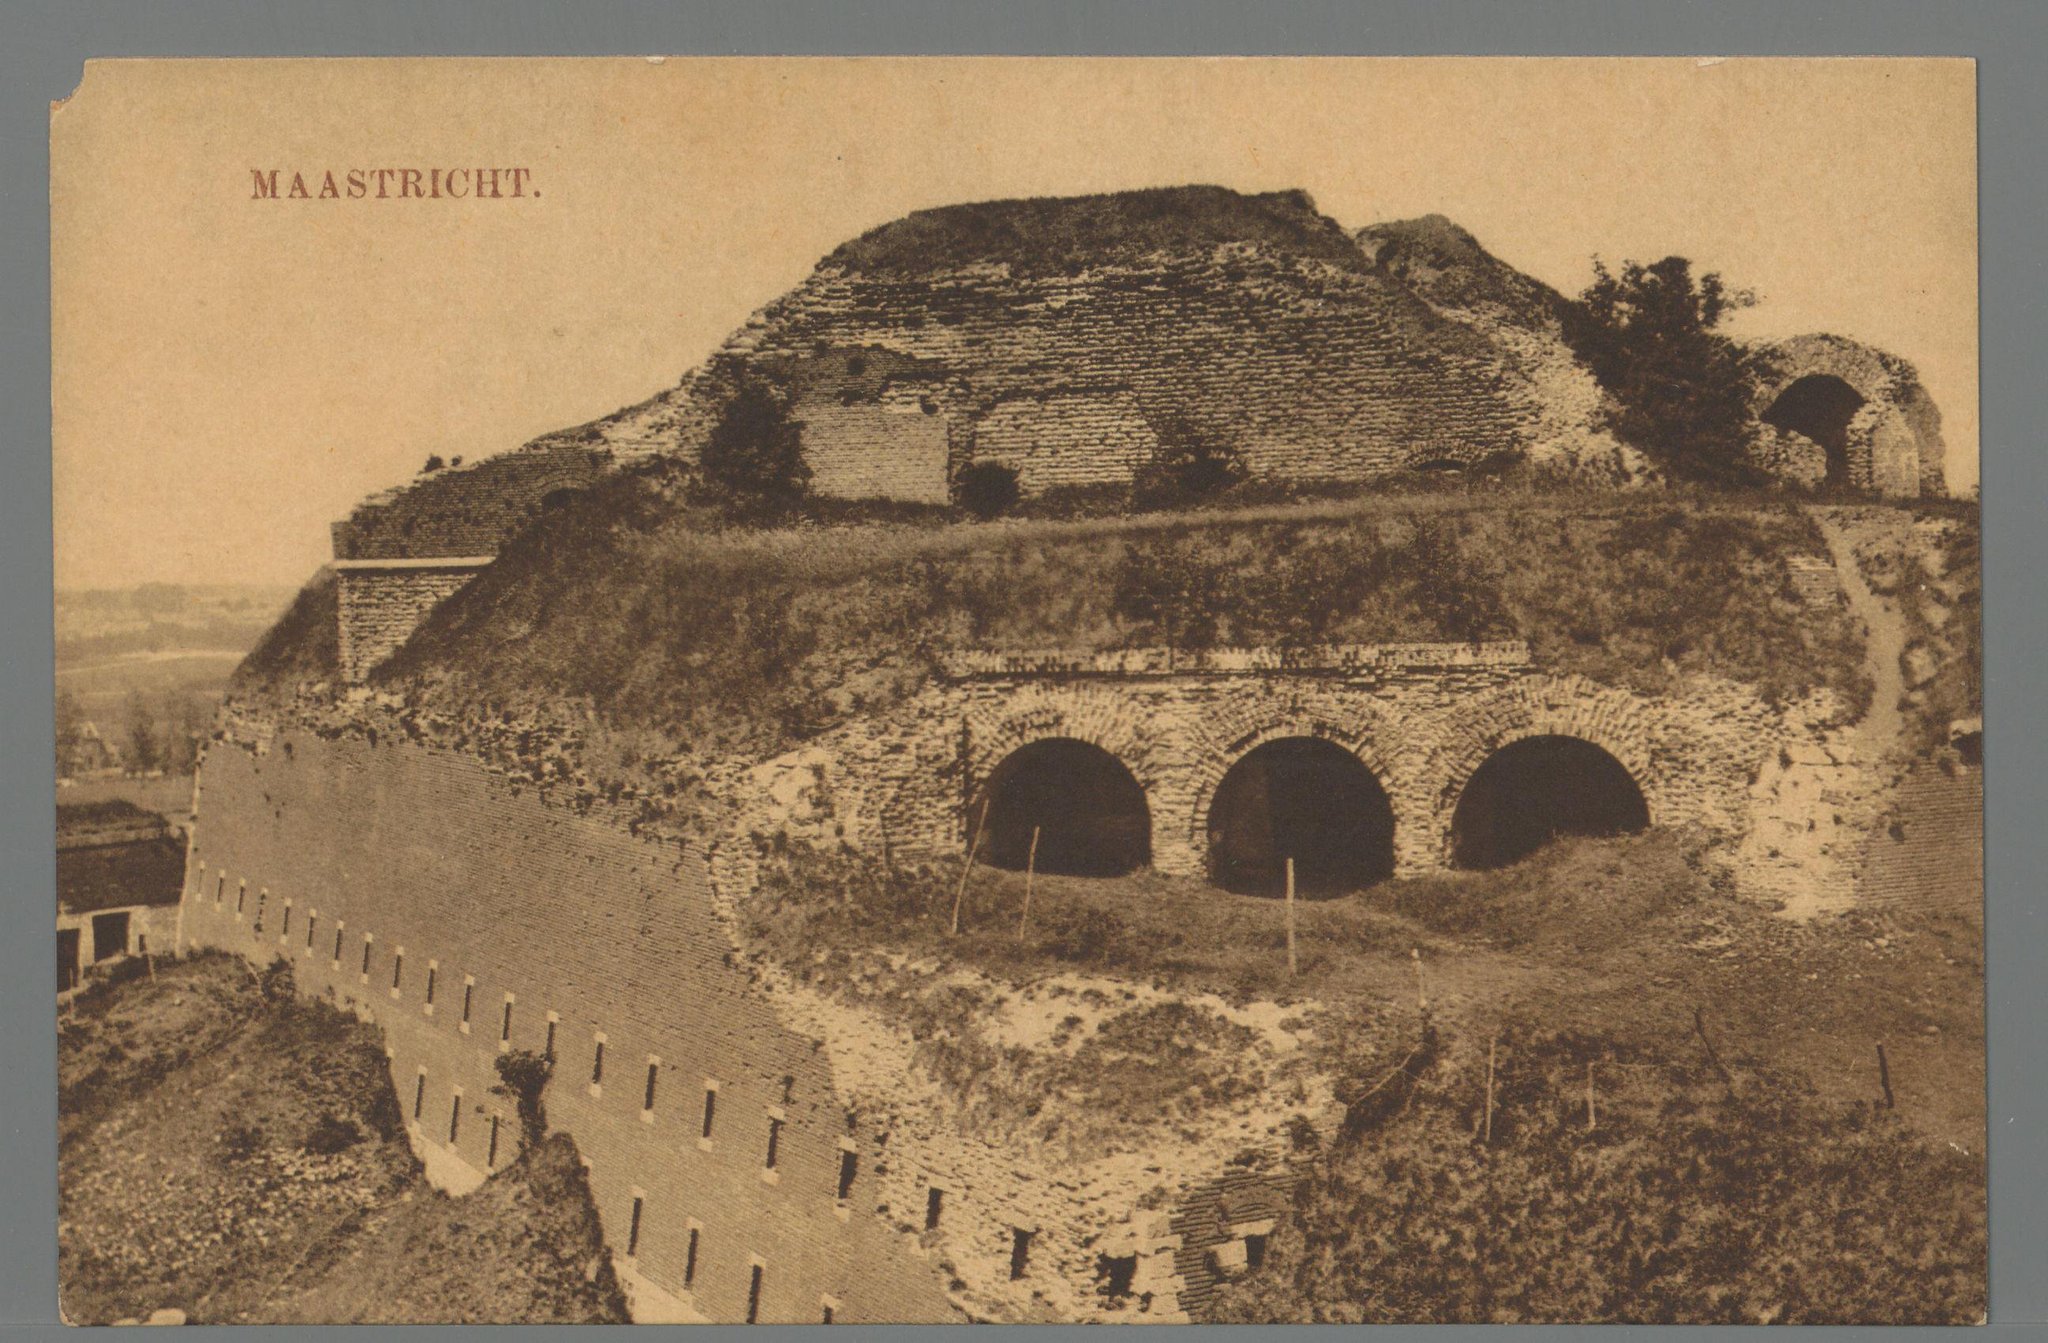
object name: photomechanical print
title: Maastricht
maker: Anonymous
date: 1905-1927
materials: cardboard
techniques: photograph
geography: maastricht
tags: castle, mountains